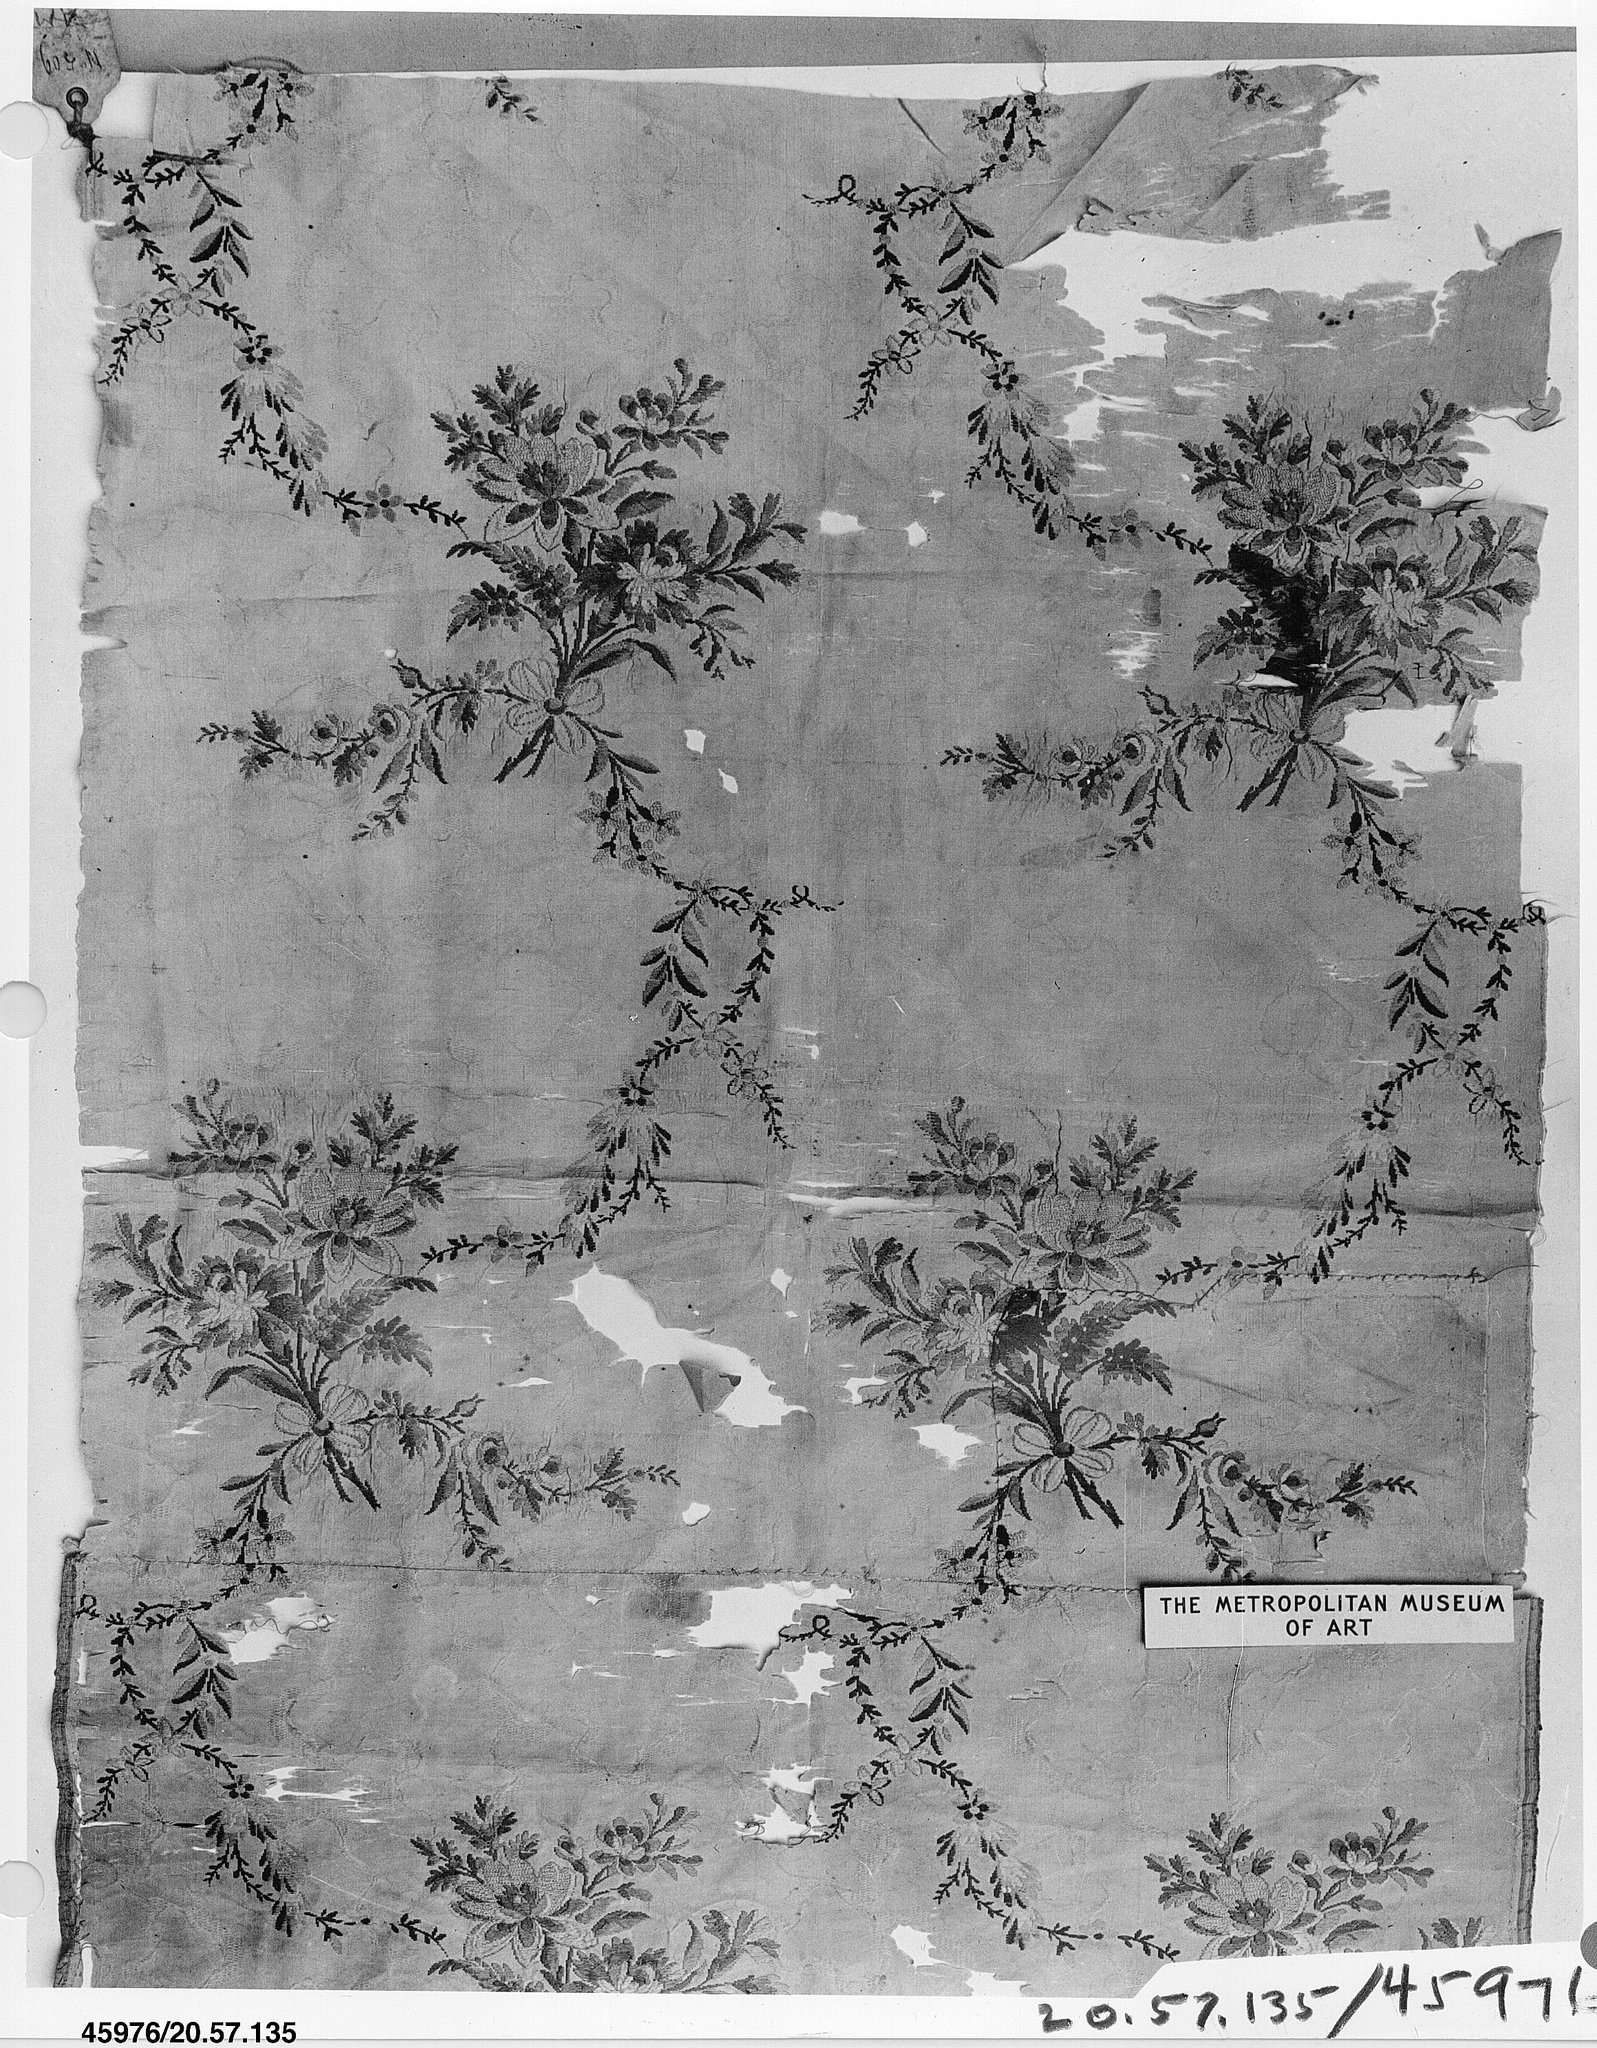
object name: piece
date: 1760-1770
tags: flowers,leaves